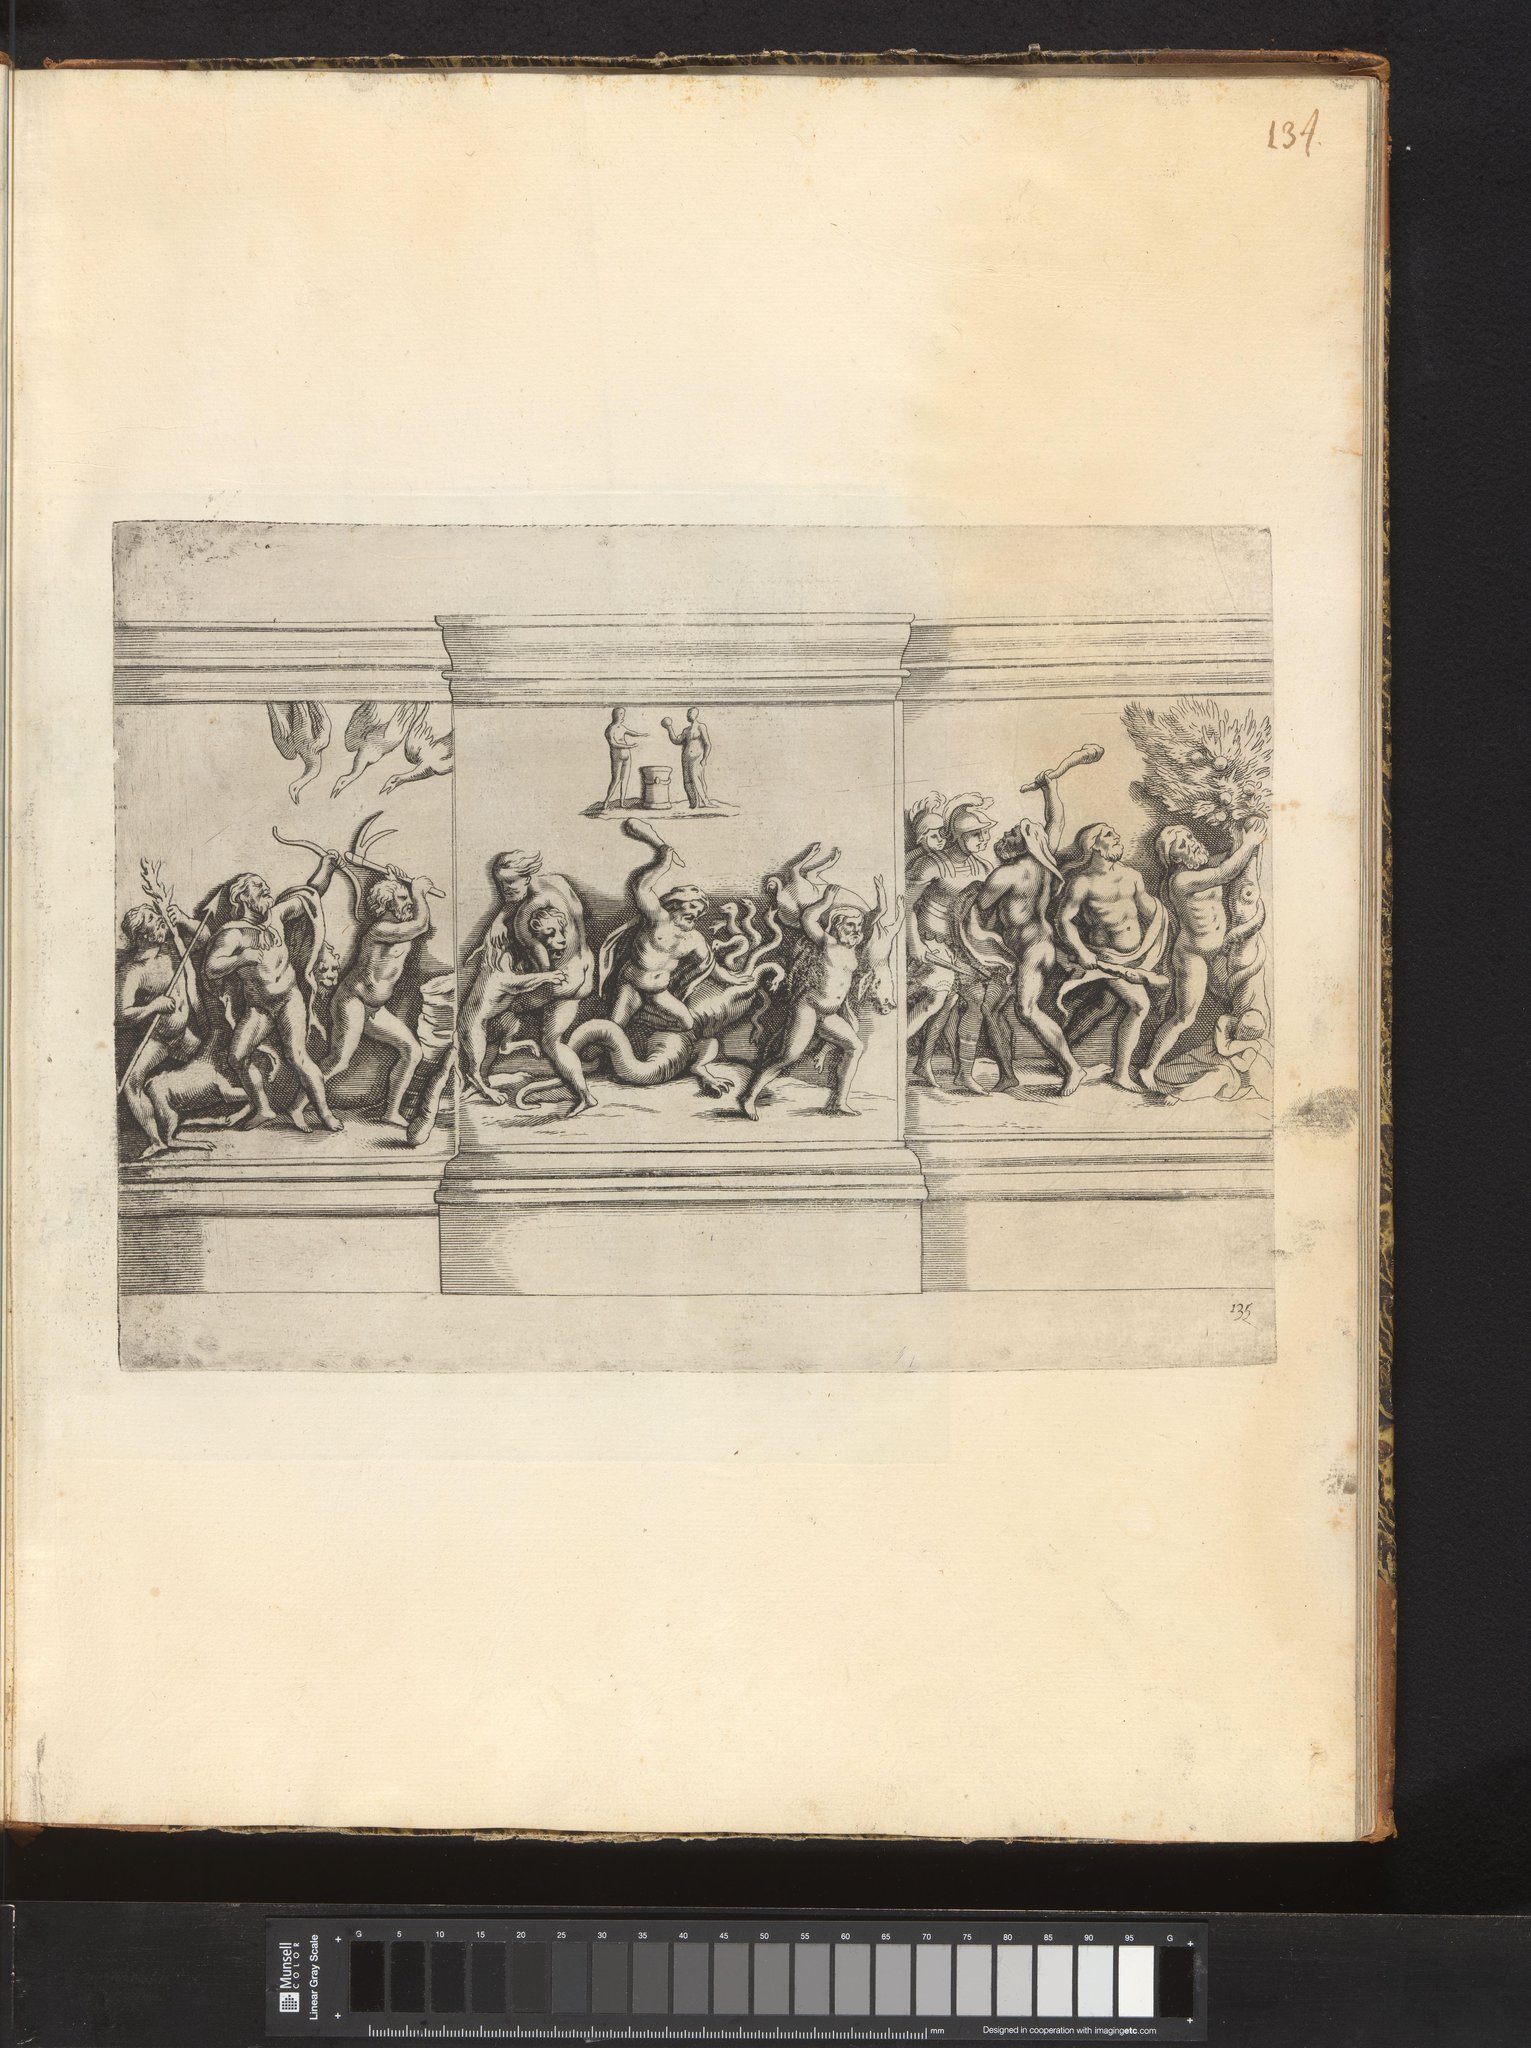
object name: album leaf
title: Bas-reliëf met de Sabijnse maagdenroof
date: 1636-1647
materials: paper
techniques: engraving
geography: rome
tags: rape of the sabine women: they are carried off by romulus and his men during a feast, piece of sculpture, reproduction of a piece of sculpture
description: Bas-reliëf met de Sabijnse maagdenroof. Midden onder het wapenschild van Vincenzo Giustiniani. Prent maakt deel uit van een album met een serie prenten naar de sculpturen in de verzameling in de Galleria Giustiniani te Rome.